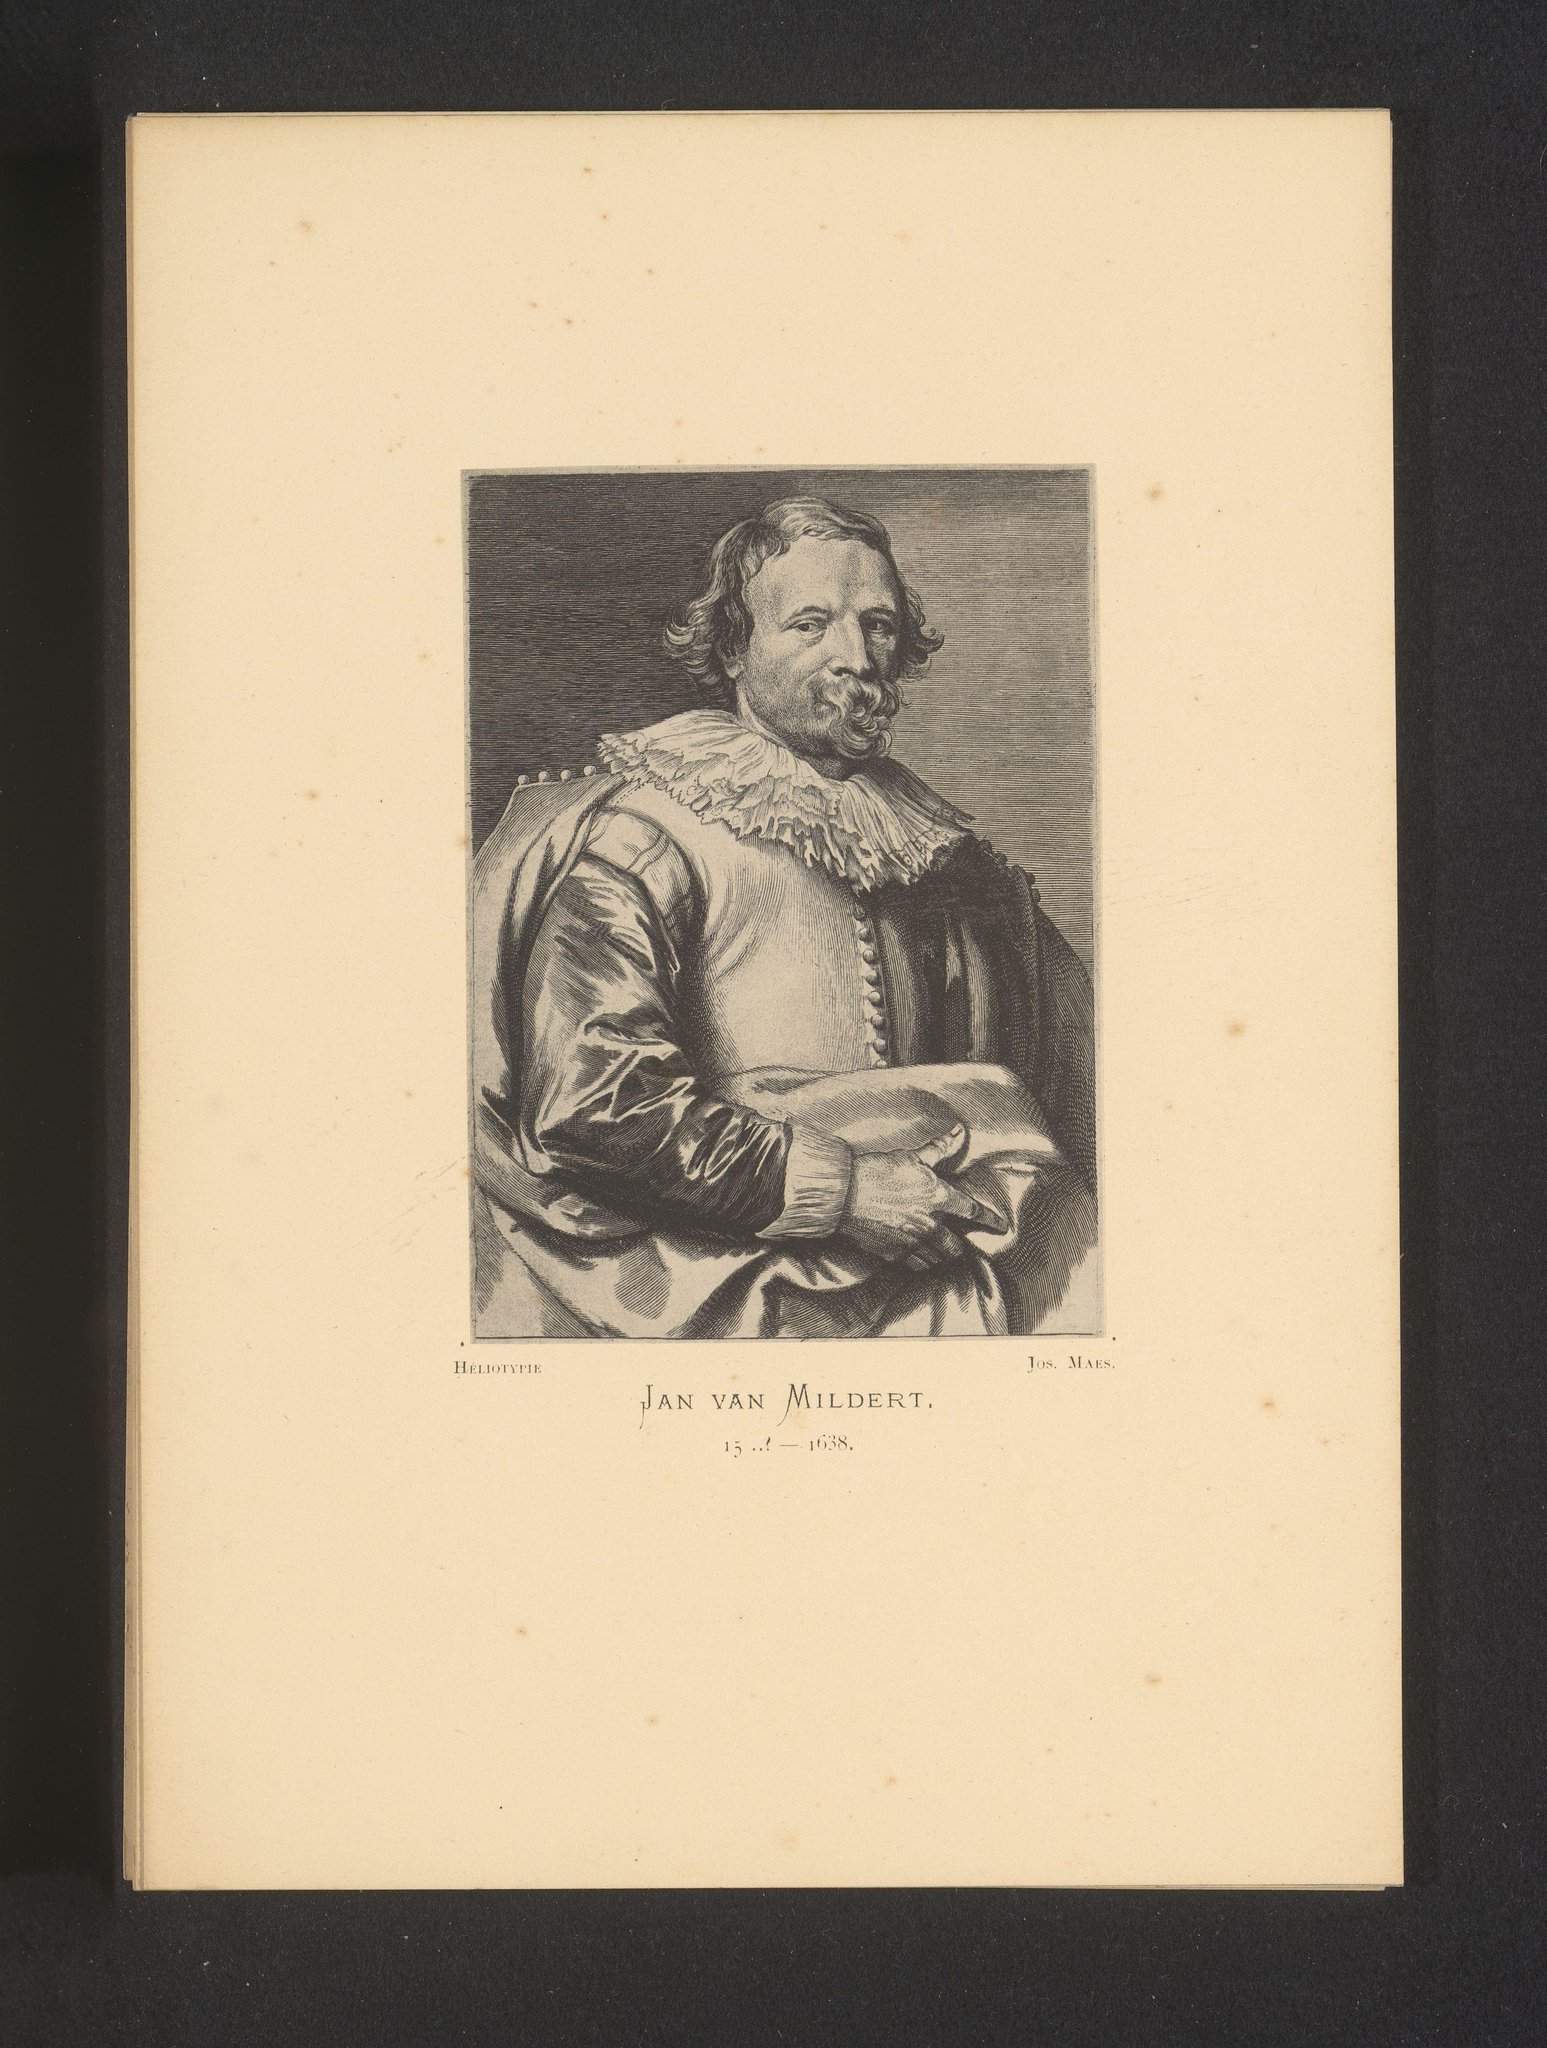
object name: photomechanical print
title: Reproductie van een gravure van een portret van Johannes van Mildert door Lucas Vorsterman (I)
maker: joseph maes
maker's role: fotograaf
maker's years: 1838-1908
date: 1872-1877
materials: cardboard, paper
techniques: photograph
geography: antwerp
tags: antwerp, sculptor, johannes van mildert, historical persons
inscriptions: inscription: ‘15..? - 1638.’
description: Deze prent maakt deel uit van een omslag met 150 prenten en een katern met een lijst van afbeeldingen.